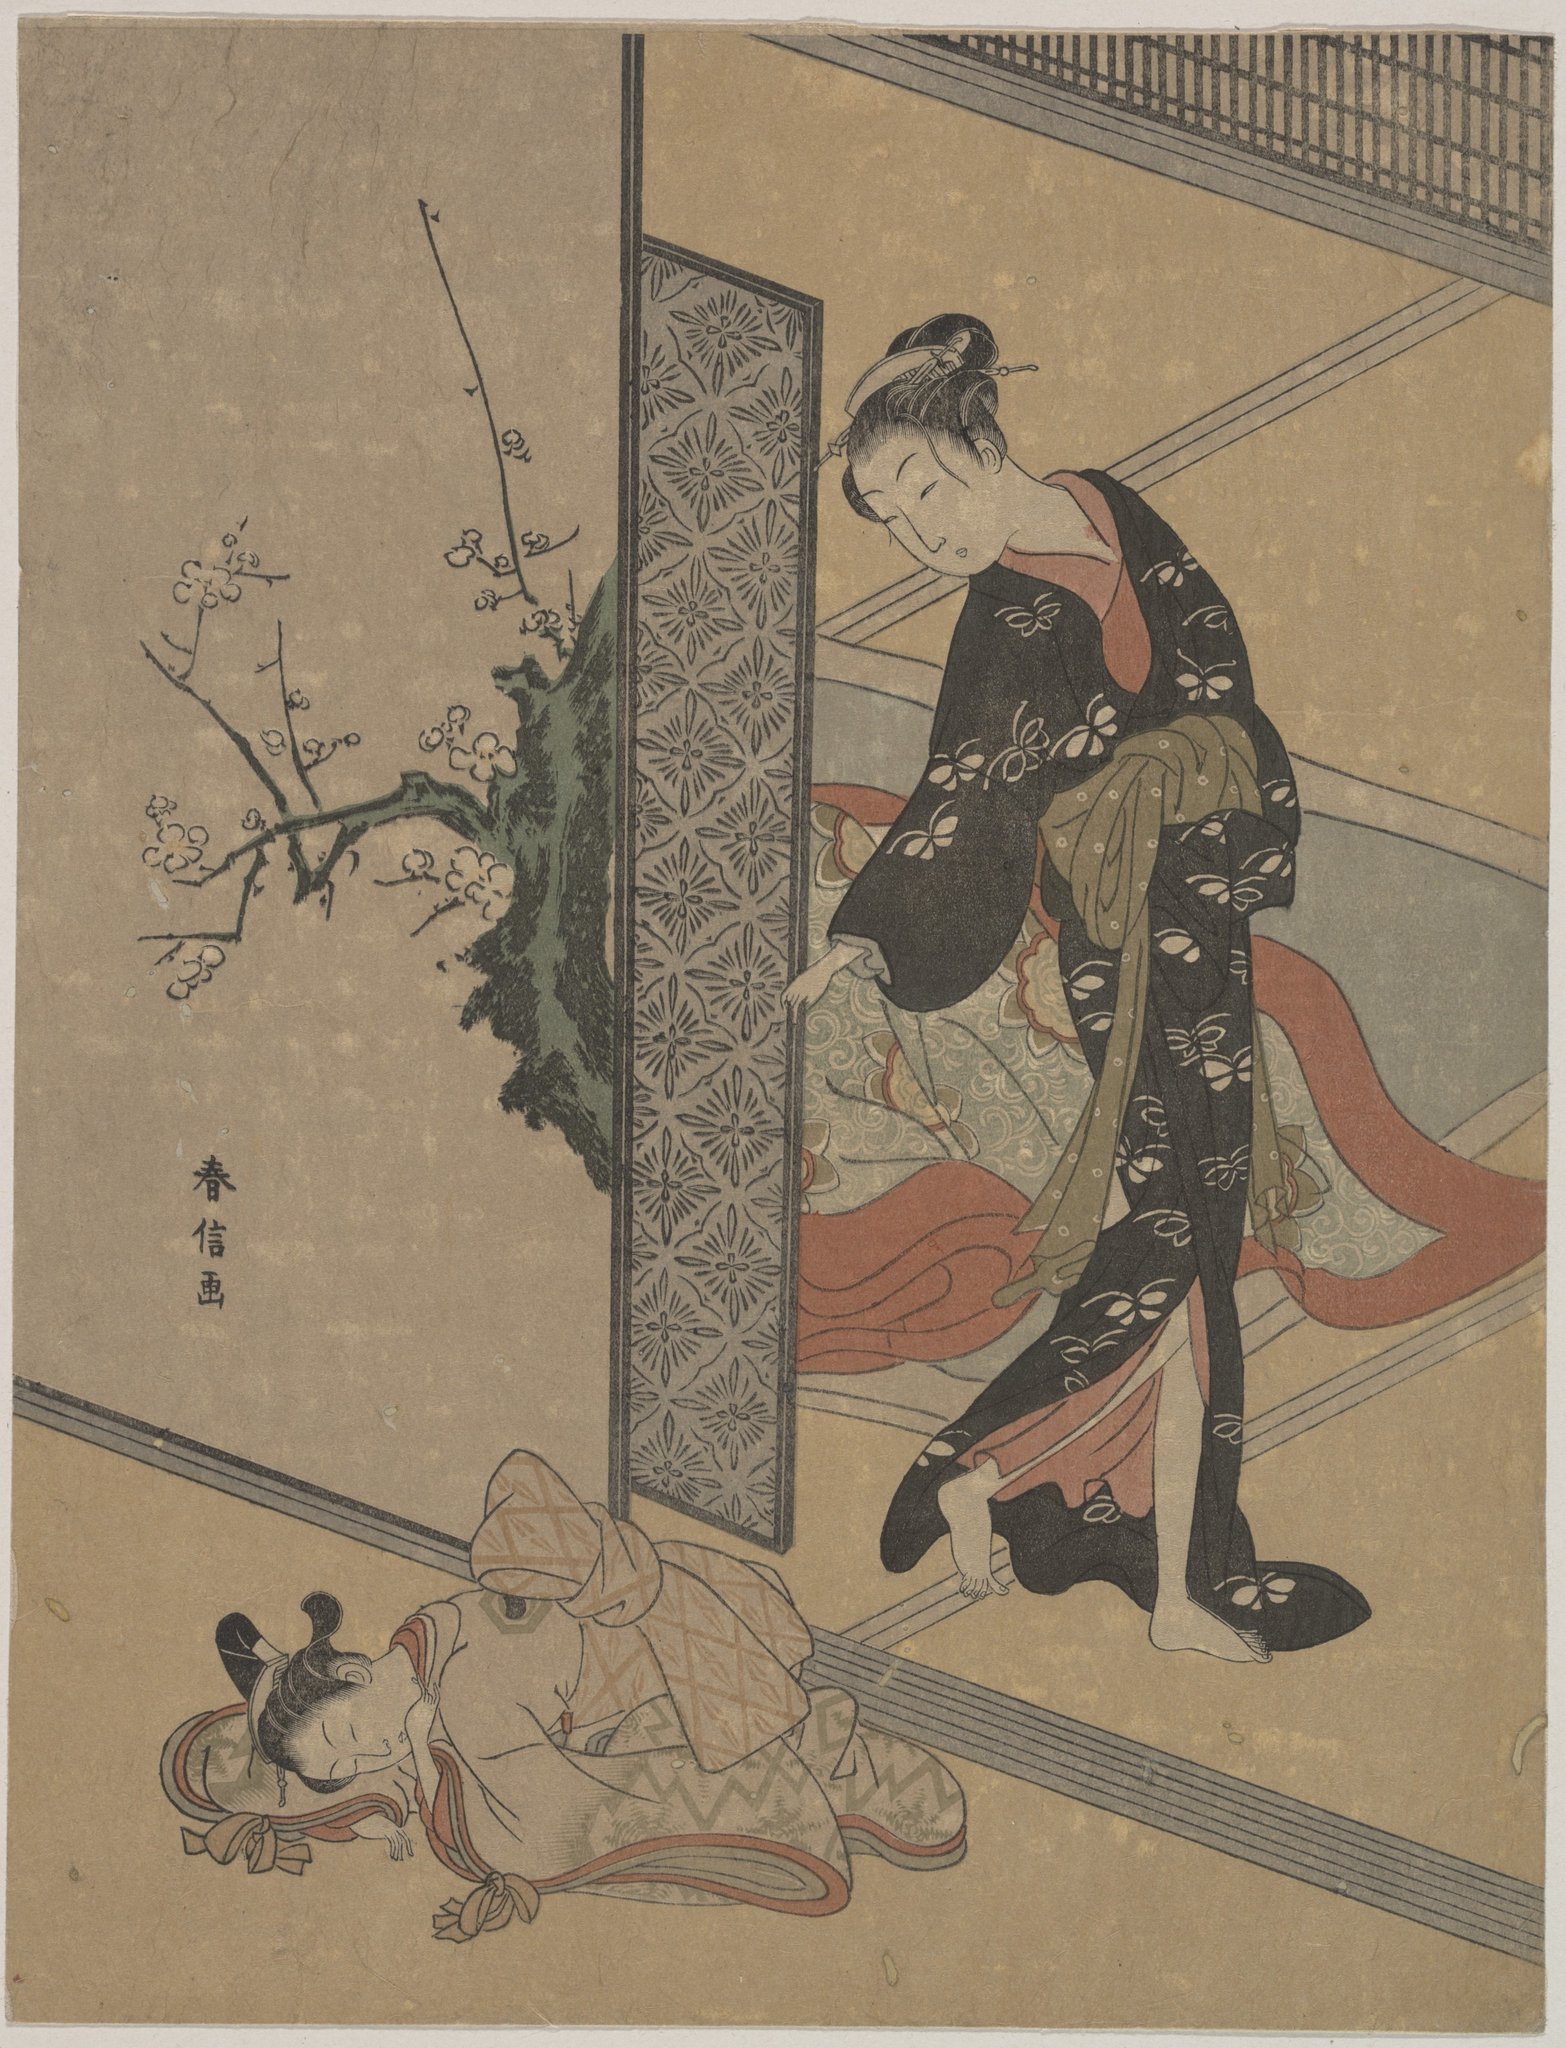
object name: print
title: Young Lady Looking through Door at Her Kamuro (Little Servant) who is Asleep on the Floor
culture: japanese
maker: suzuki harunobu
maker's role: artist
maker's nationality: japanese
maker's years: 1725-1770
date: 1725-1770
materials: ink, paper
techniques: woodblock print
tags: sleeping,women,servants